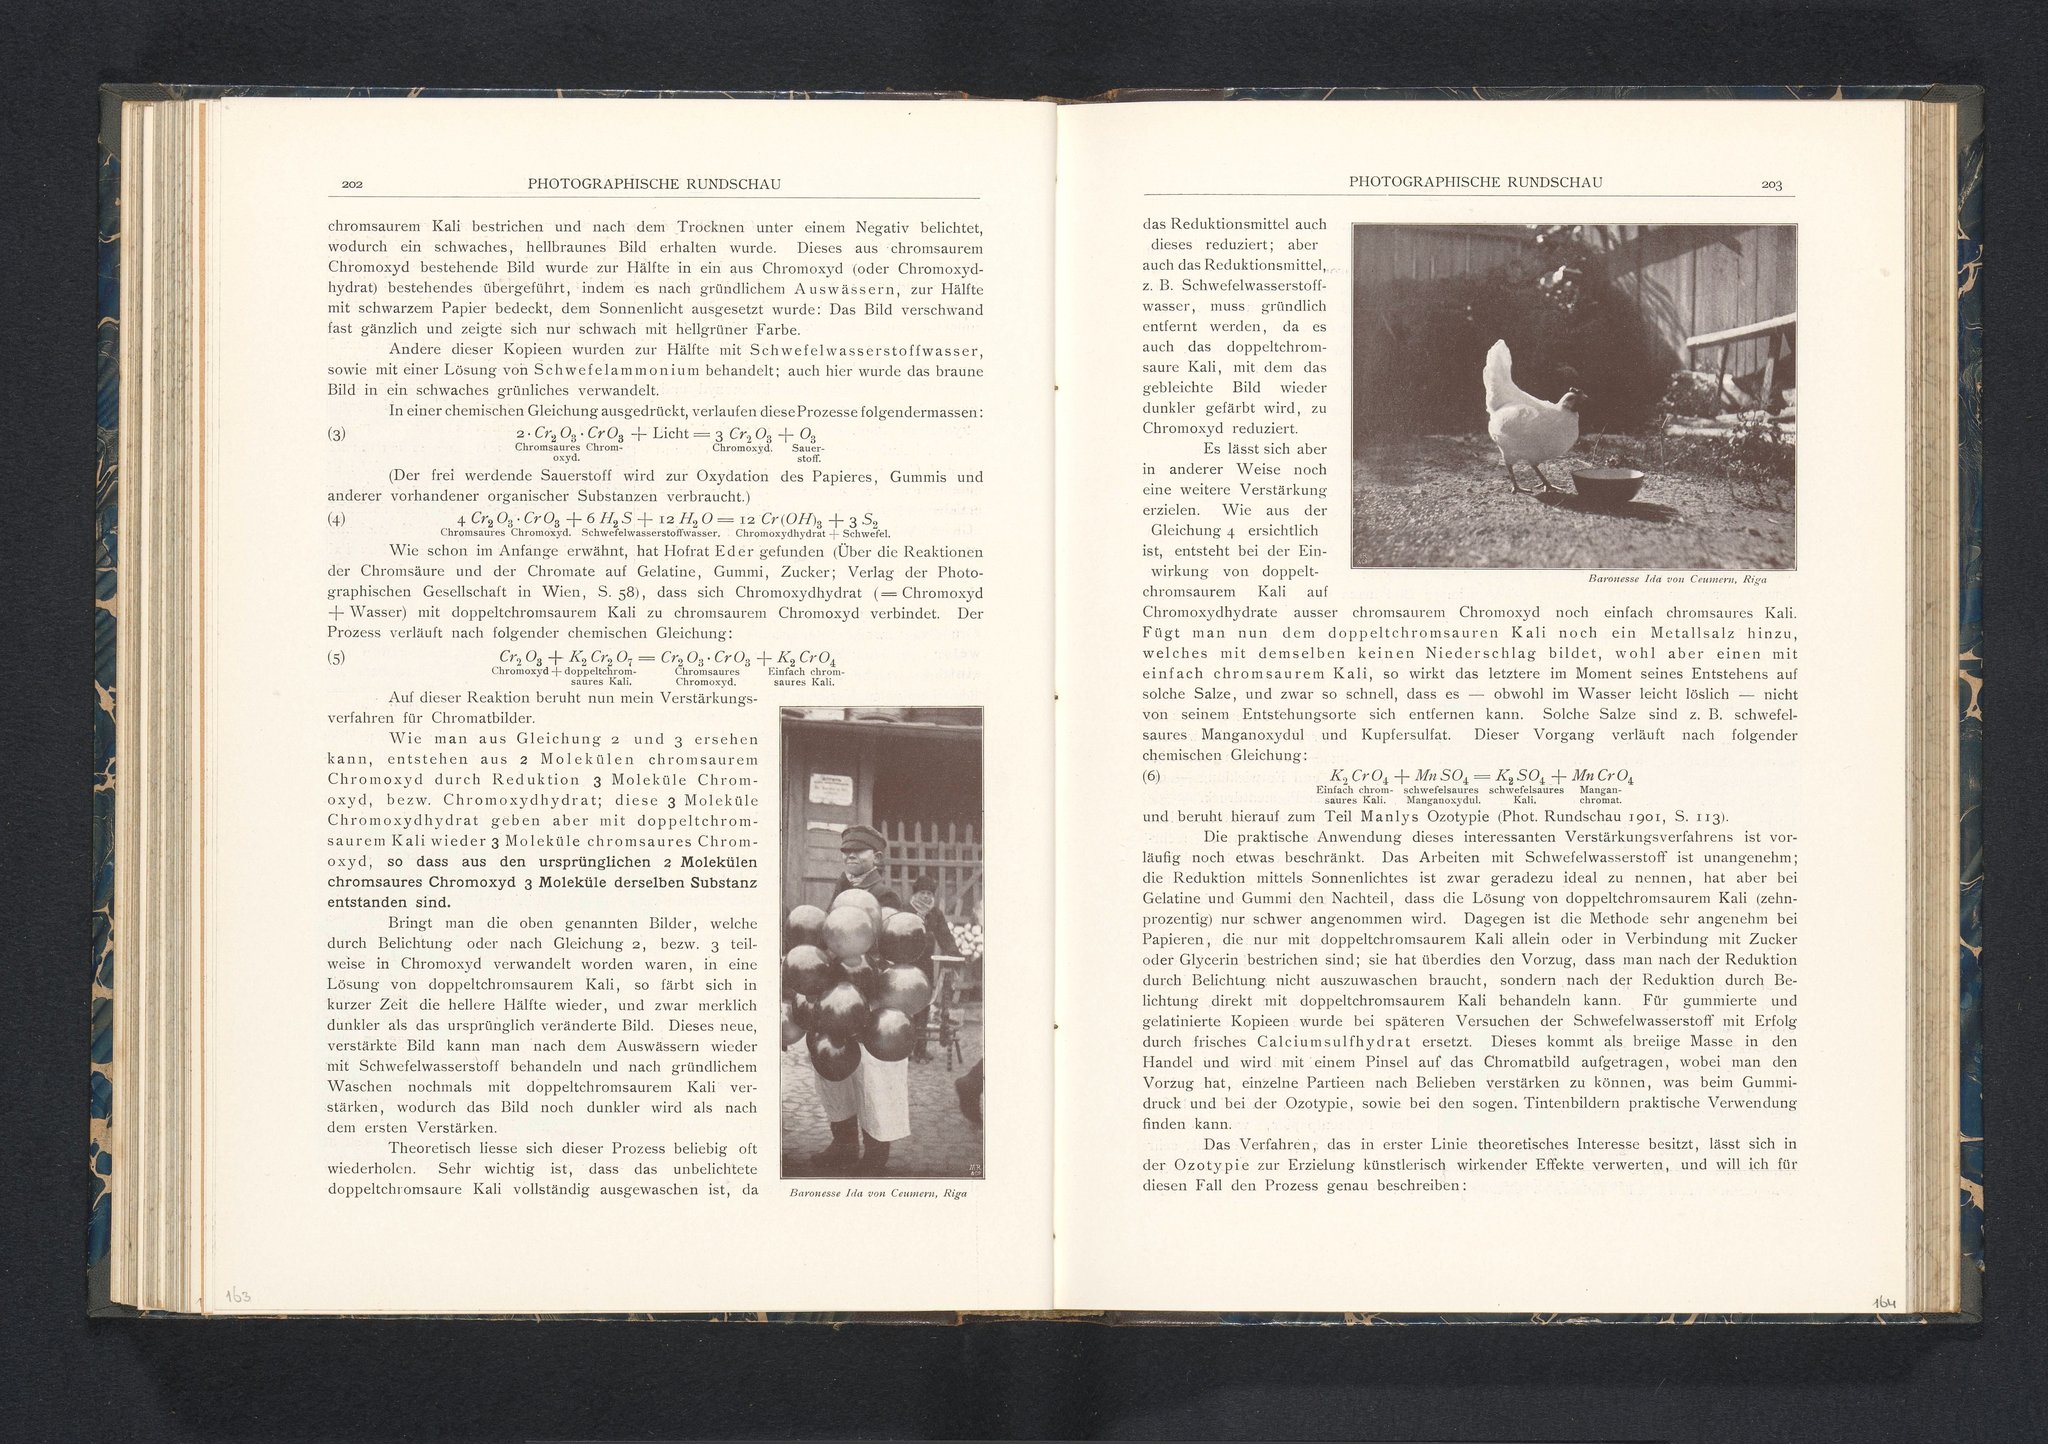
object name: page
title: Kip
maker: ida von ceumern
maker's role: barones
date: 1896-1901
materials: paper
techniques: autotype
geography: berlin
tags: fowl (cock, hen, chicken, etc.)